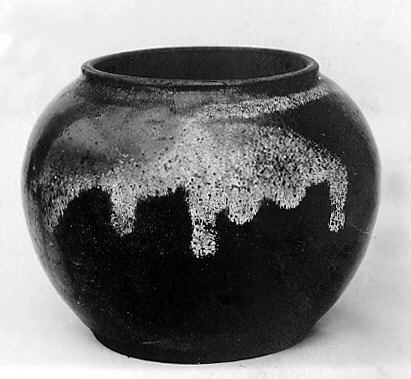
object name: jar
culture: japanese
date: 1801-1900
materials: clay, glaze